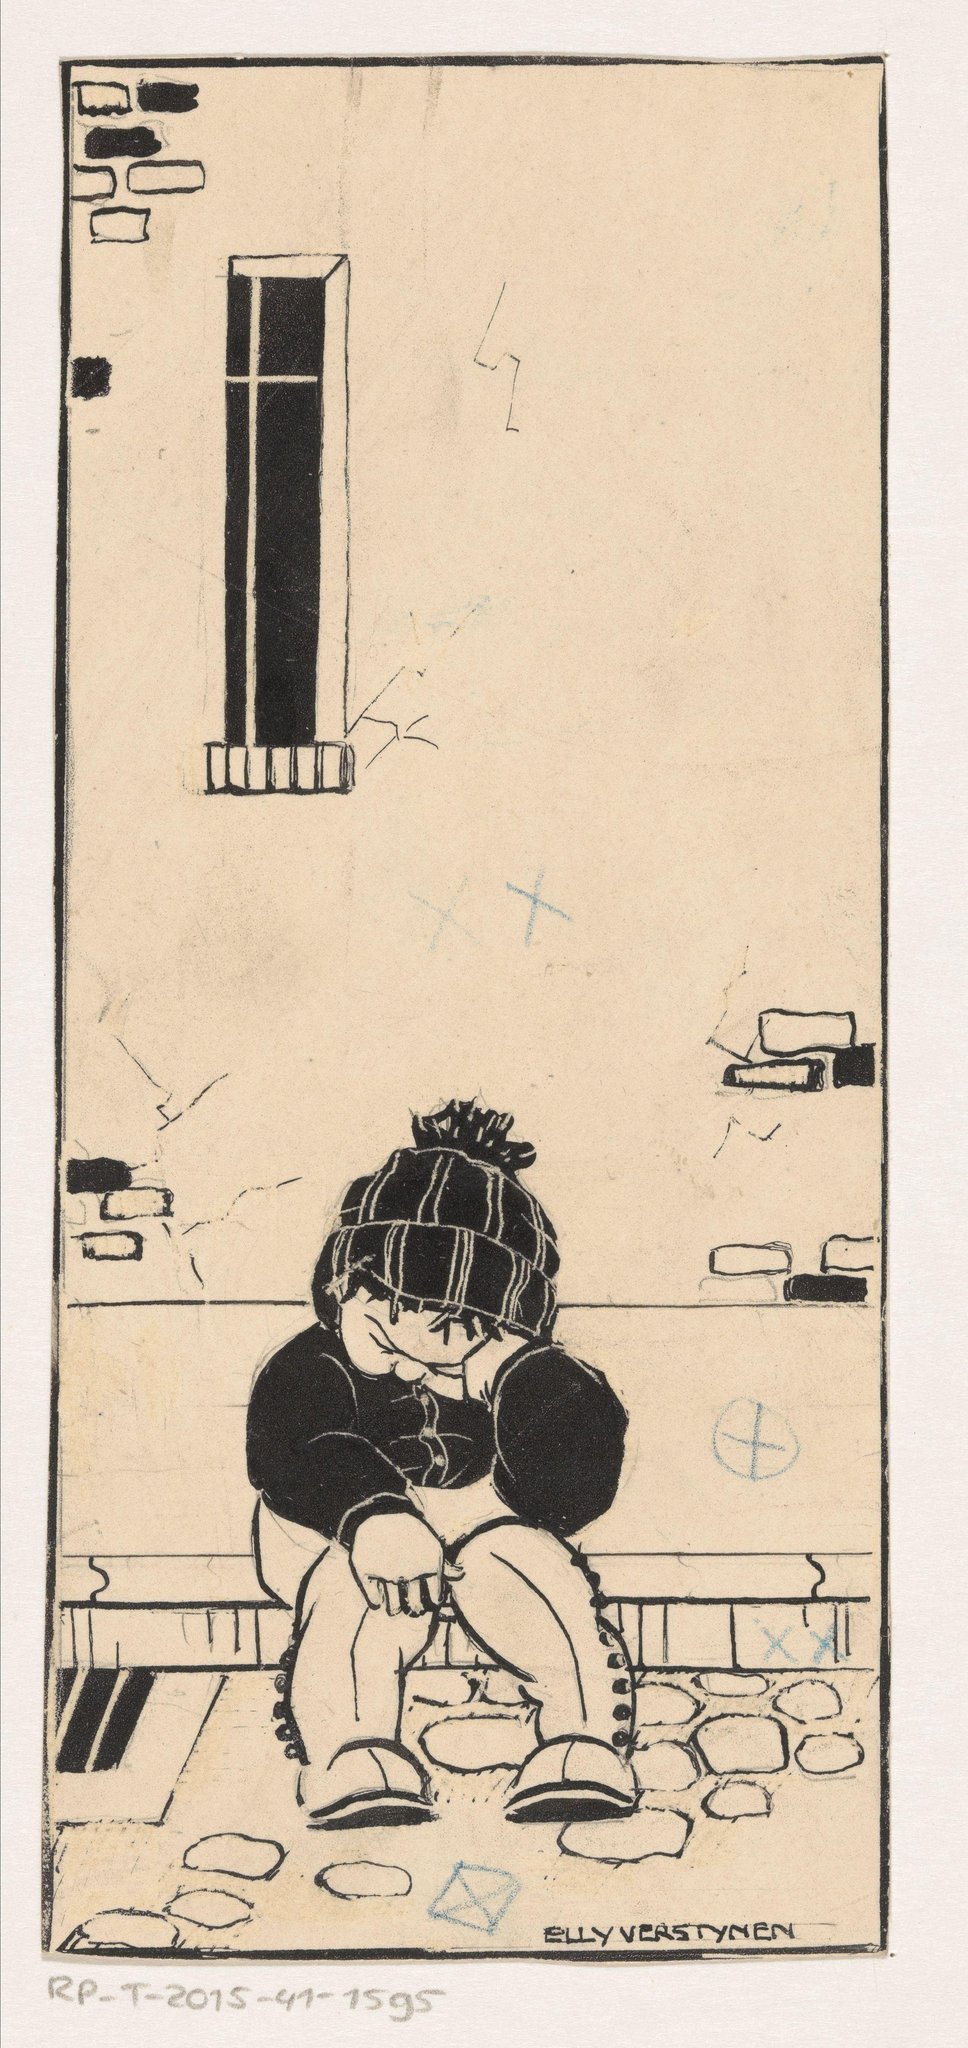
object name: drawing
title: Zittende jongen op een stoep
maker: elly verstijnen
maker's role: draughtsman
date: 1900-1930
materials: ink, paper, pencil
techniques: brush, pen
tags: head-gear: hat, street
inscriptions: signature: ‘ELLY VERSTYNEN’, :, collector's mark: Lugt 2228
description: Een jongen met een muts op het hoofd zit op een stoep. Hij heeft zijn kin op zijn borst en ondersteunt zijn hoofd met zijn vuist.